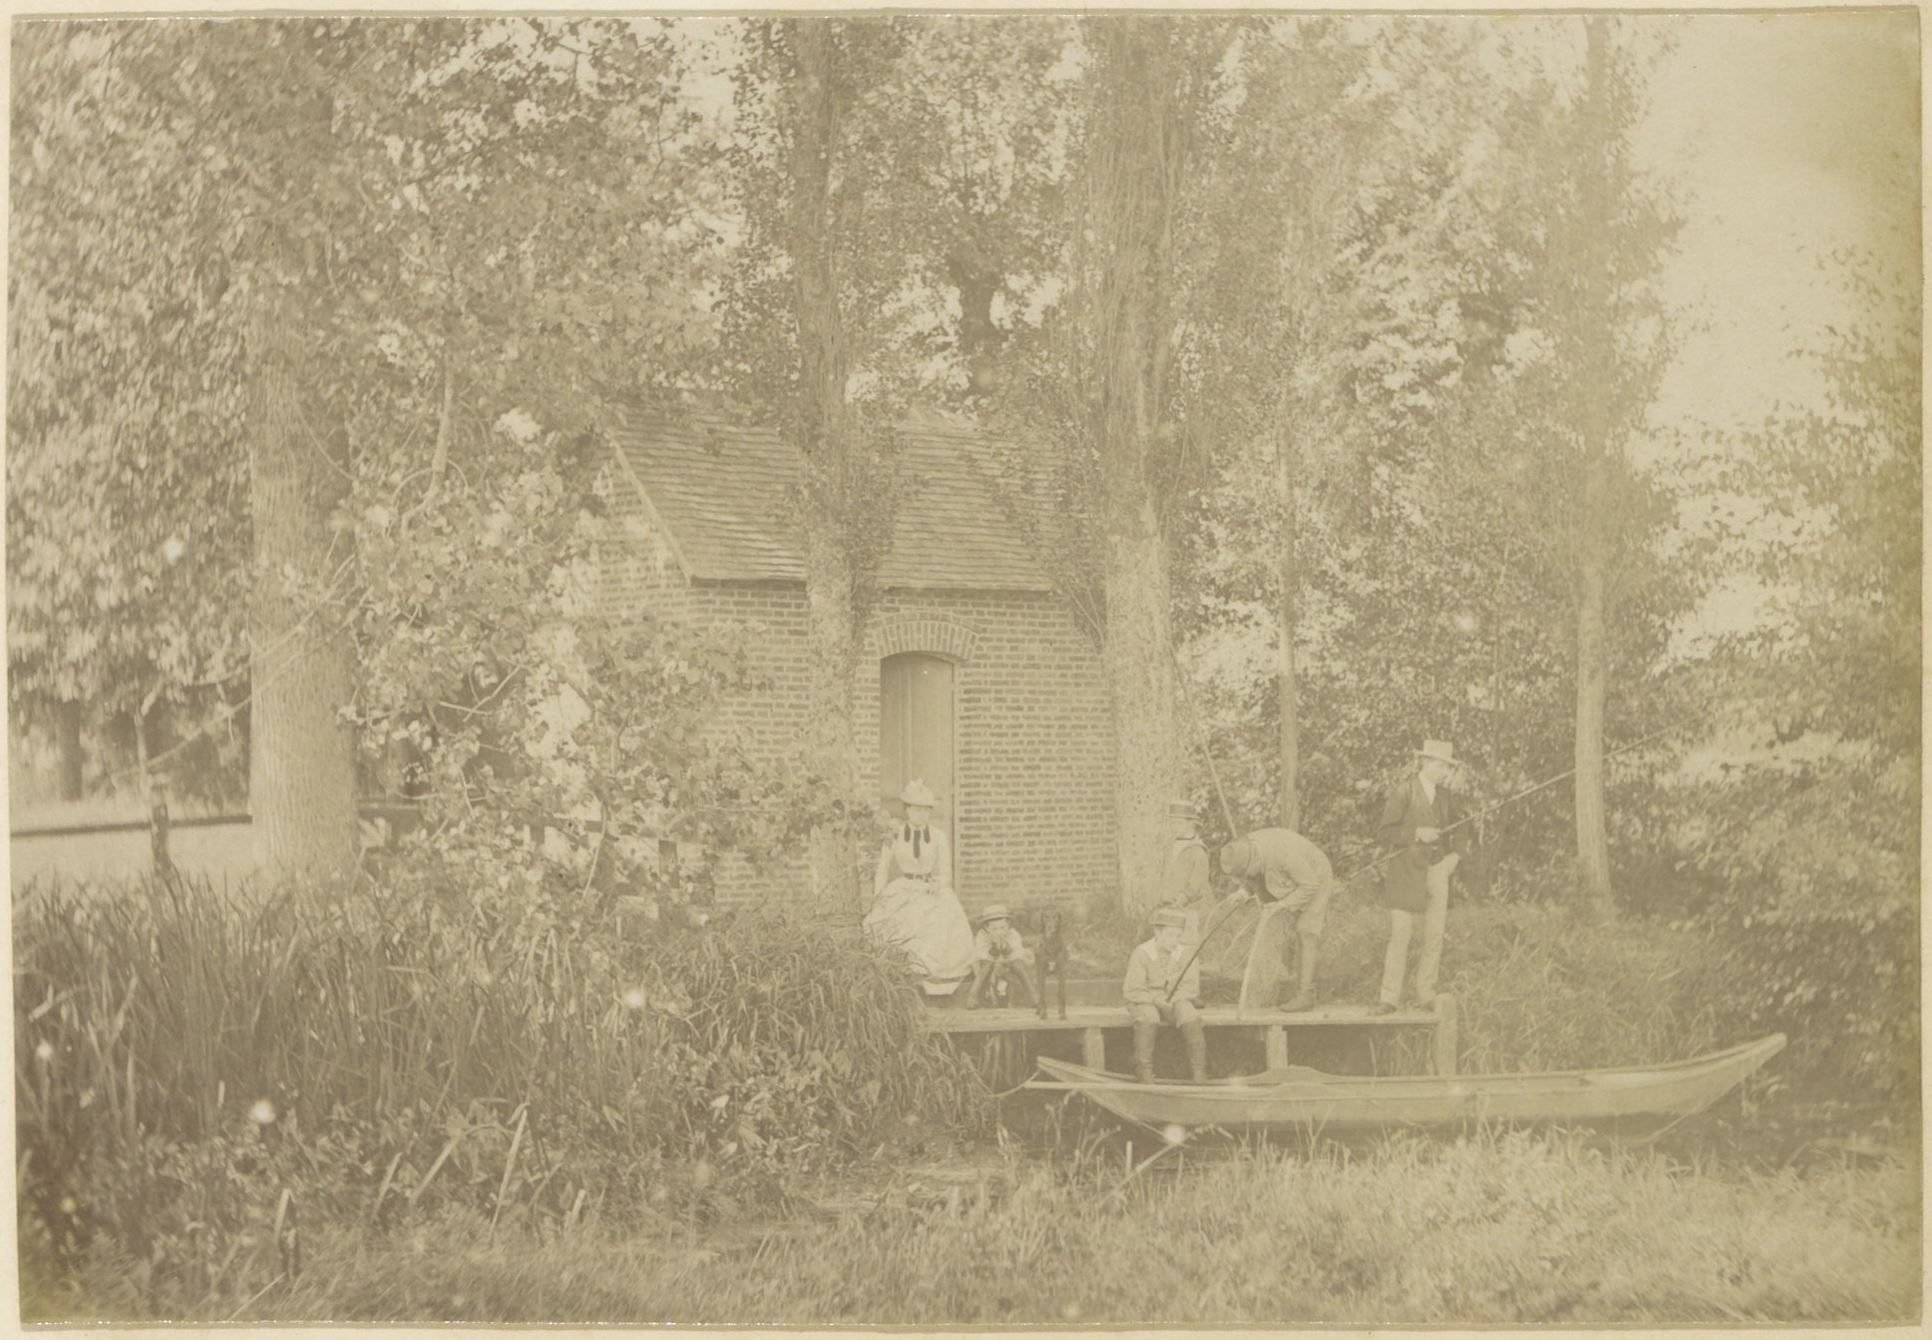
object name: photograph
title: Gezelschap hengelend aan de oever van een sloot in Frankrijk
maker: Anonymous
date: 1900-1910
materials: paper, photographic support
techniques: albumen print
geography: france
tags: parents with their children, rowing-boat, canoe, etc., angling, france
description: Onderdeel van Fotoalbum van een Franse amateurfotograaf met opnames van een familie, distilleerderij Delizy & Doistau Fils, het leger en bezienswaardigheden in Frankrijk.